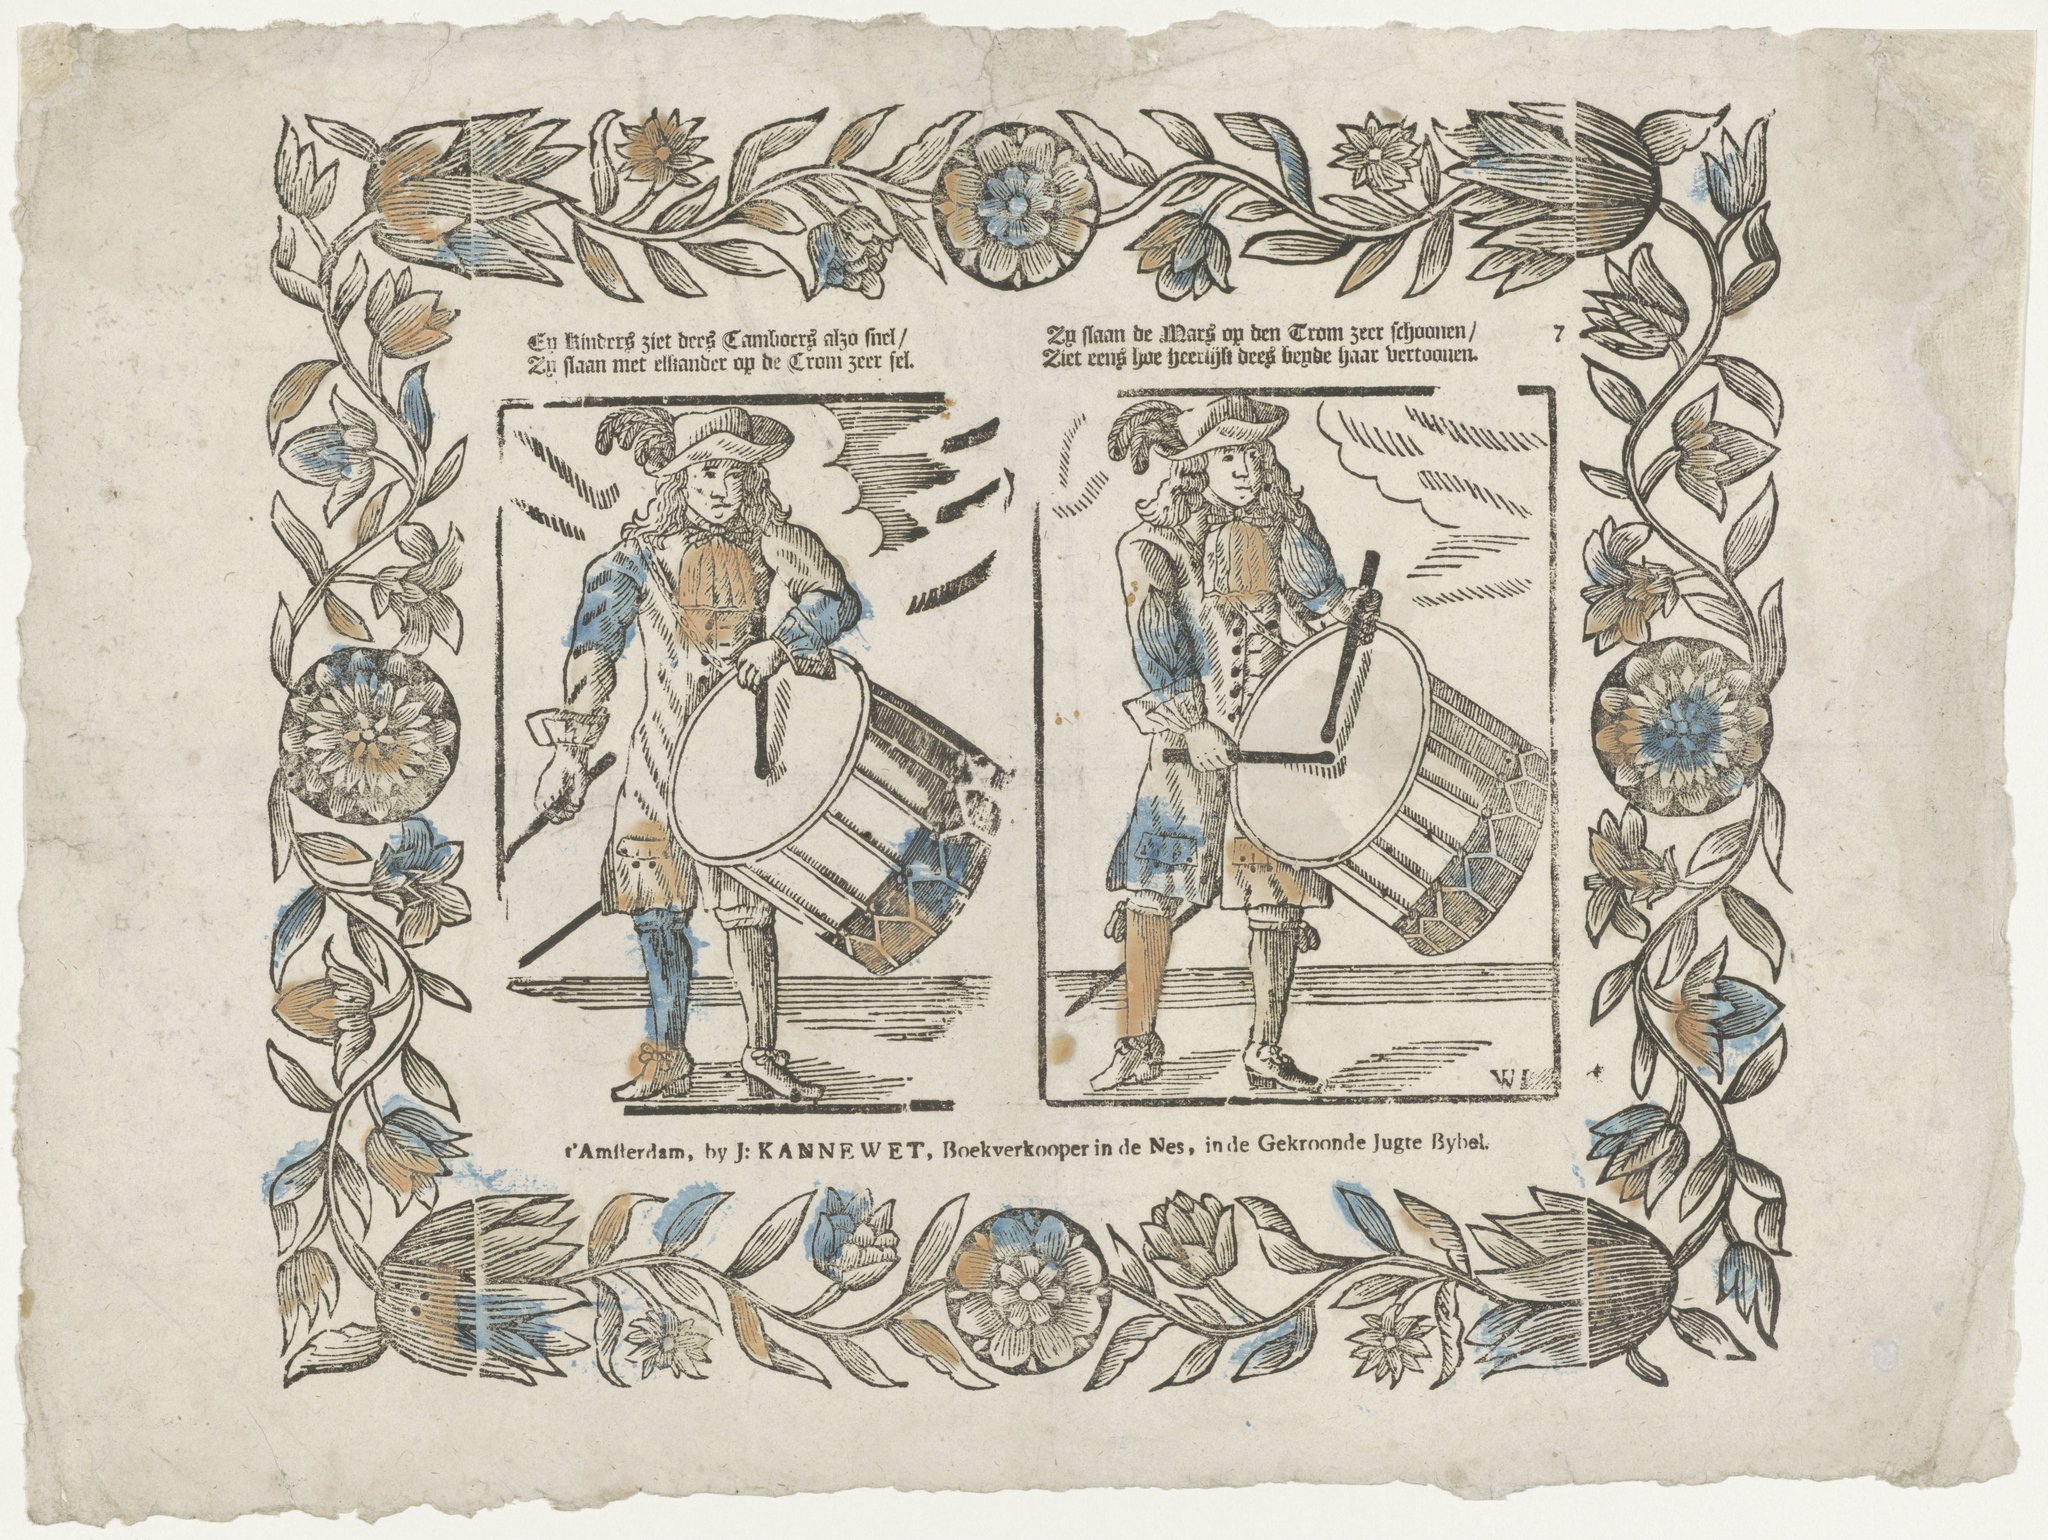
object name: popular print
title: Ey kinders ziet dees tamboers alzo snel / Zu slaan met elkander op de trom zeer fel / Zy slaan de mars op den trom zeer schoonen / Ziet eens hoe heerlijk dees bende haar vertoonen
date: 1725-1780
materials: paper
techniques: colour, letterpress printing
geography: netherlands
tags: floral interlace ~ ornament, drum (musical instrument) - cc - out of doors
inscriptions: collector's mark: Lugt 2760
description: Blad met 2 voorstellingen van tamboers. Het geheel is gevat in een sierlijst met ranken, dieren en bloemen. Genummerd rechtsboven: 7.